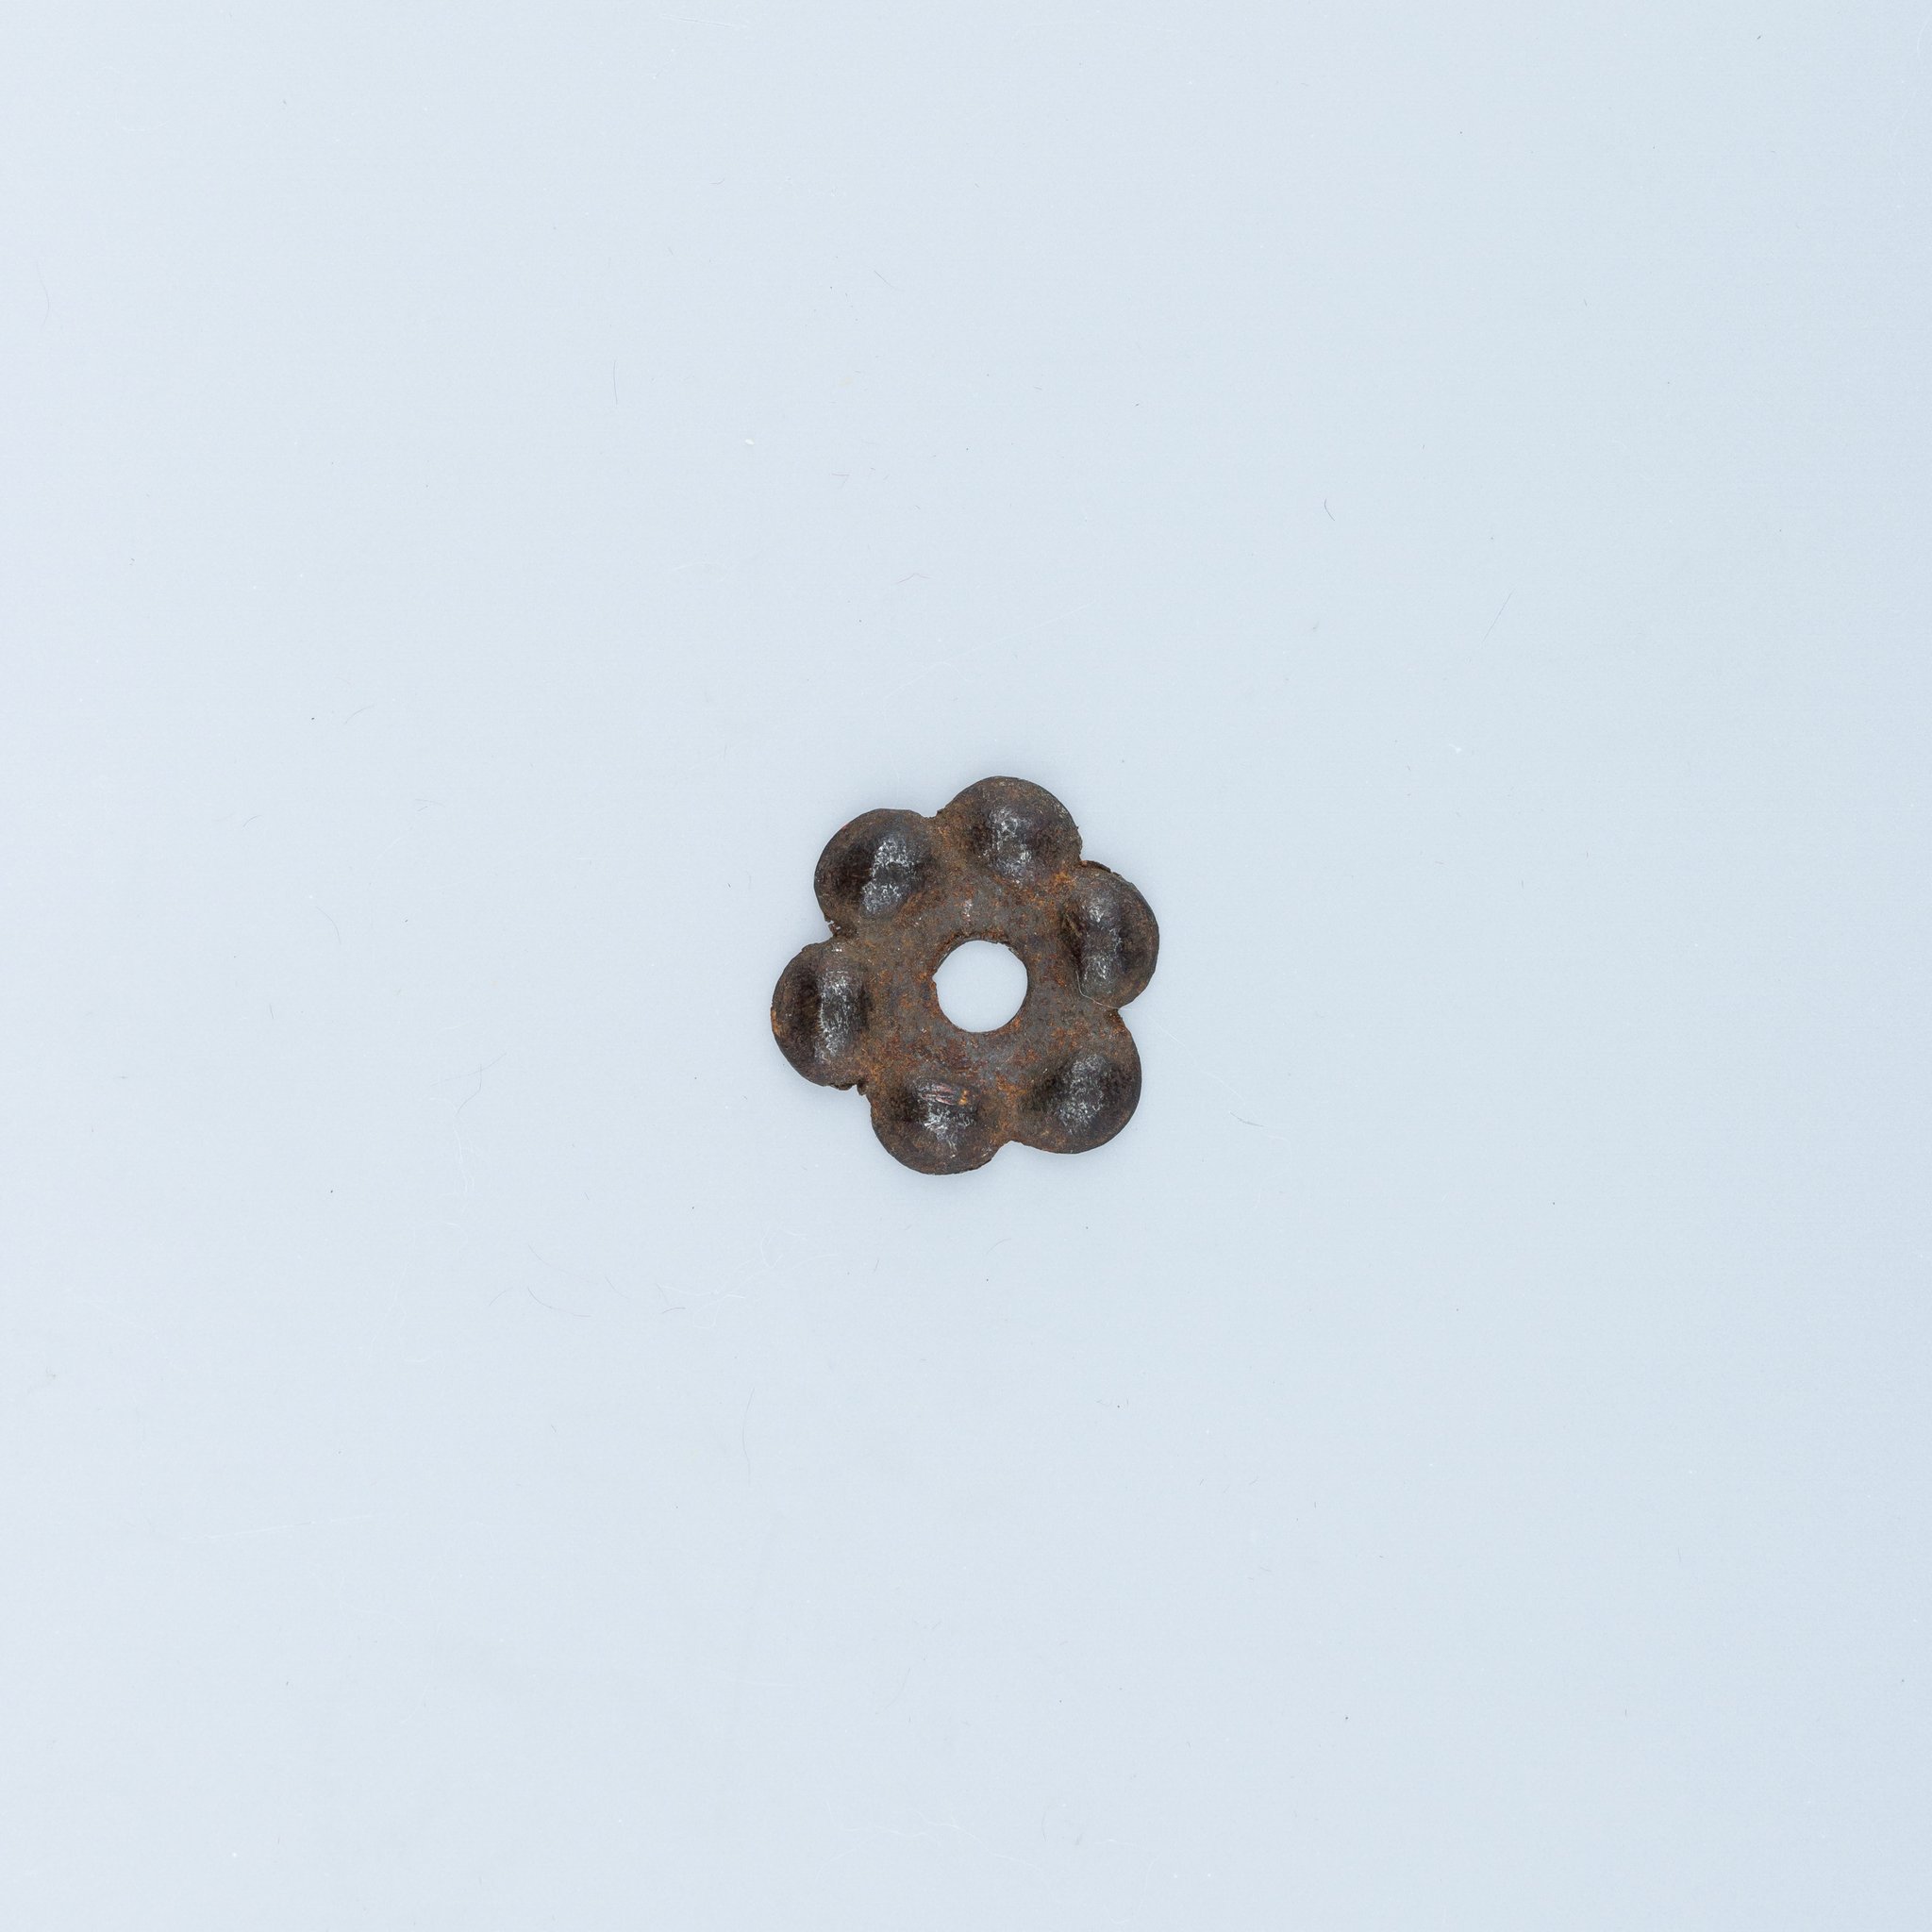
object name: rosette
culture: german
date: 1530-1550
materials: steel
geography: germany